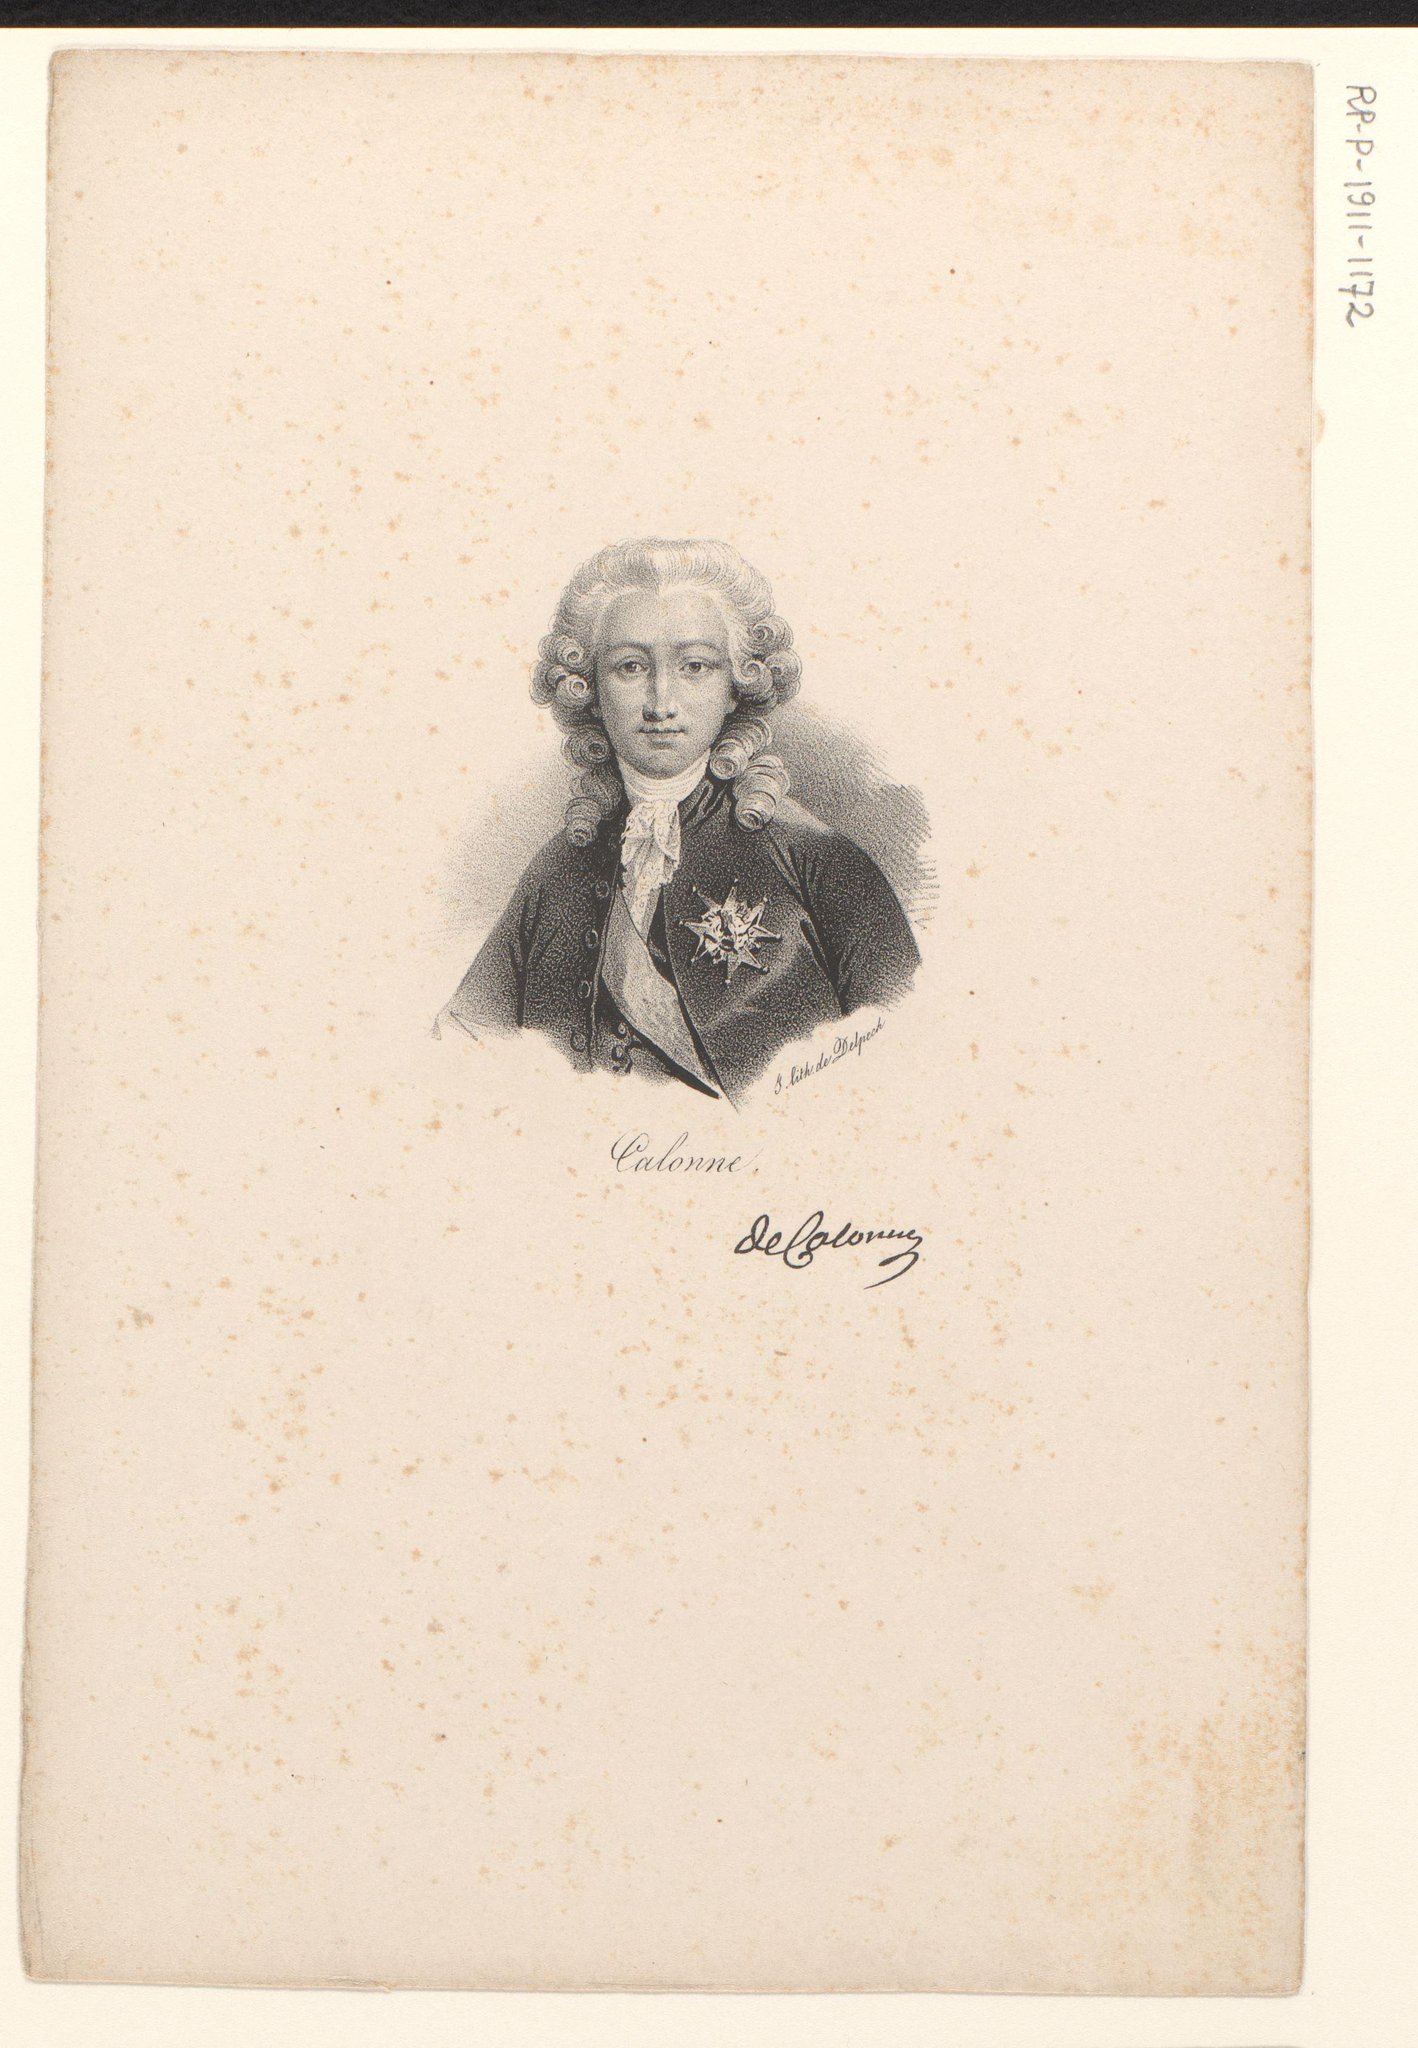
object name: print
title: Calonne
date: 1818-1842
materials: paper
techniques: lithograph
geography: paris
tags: paris, politician, charles-alexandre de calonne, historical persons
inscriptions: collector's mark: Lugt 2228a